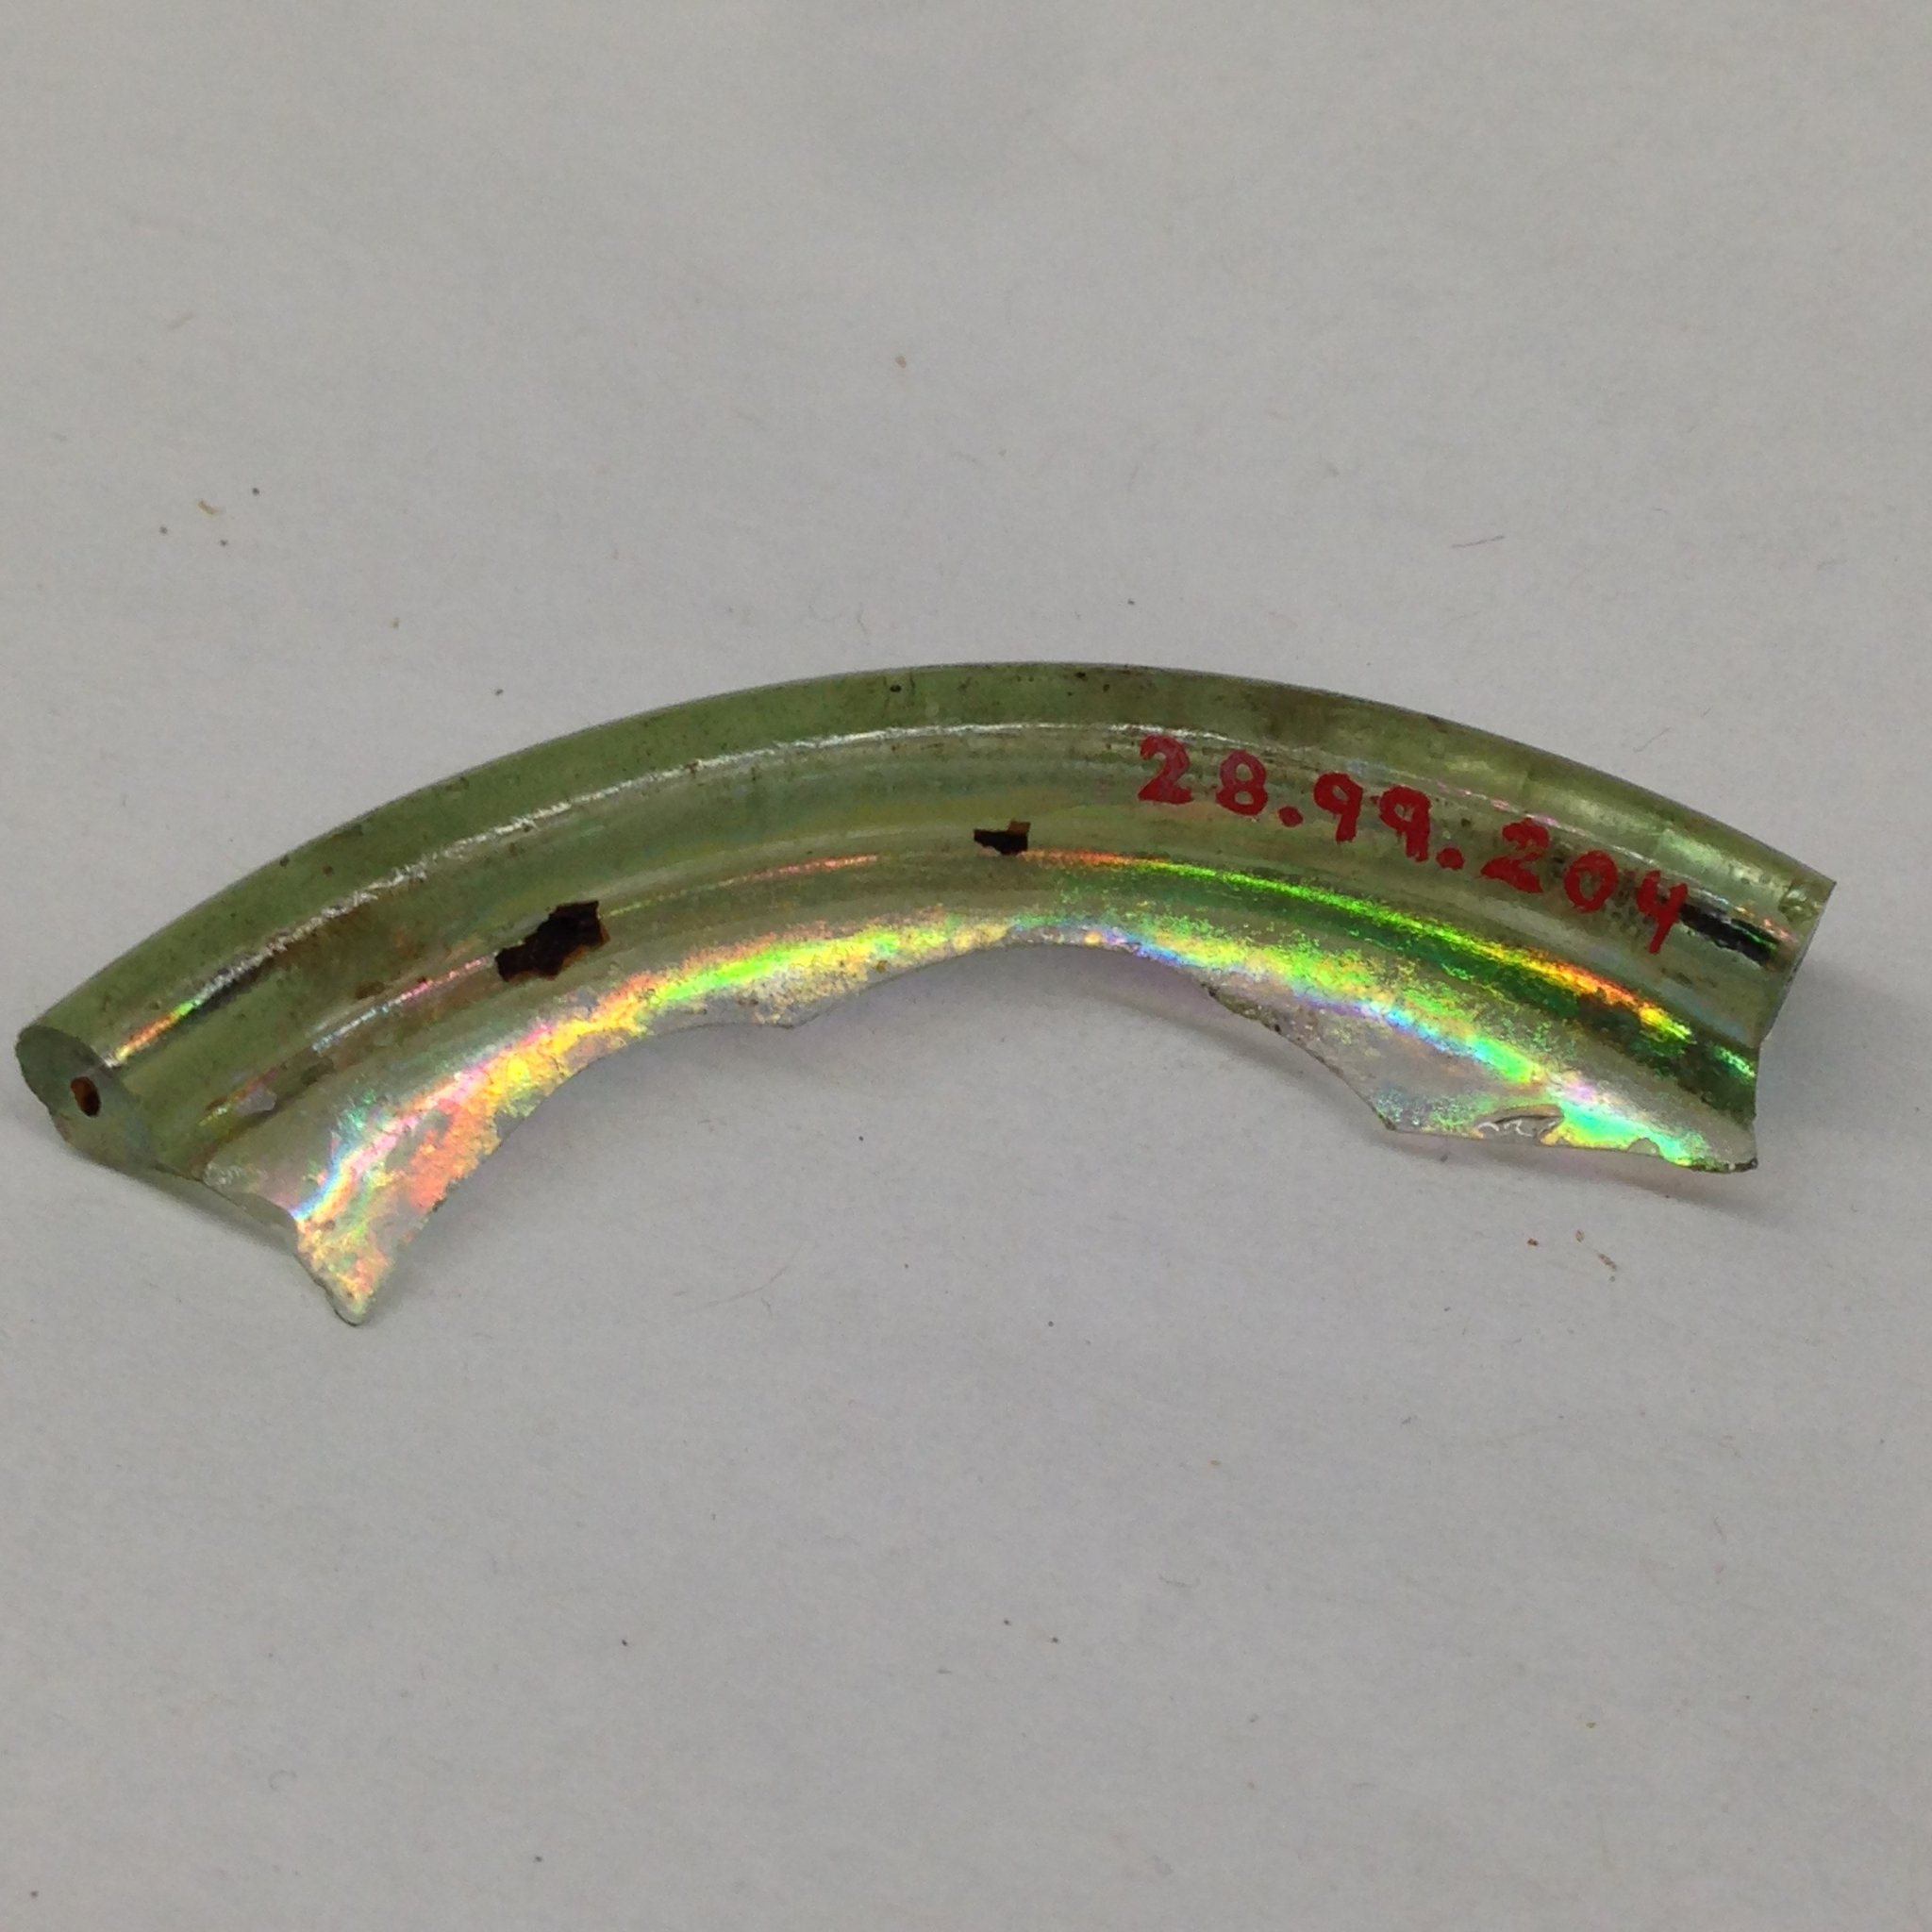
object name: fragment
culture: european or middle eastern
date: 1150-1250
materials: ceramic, glass